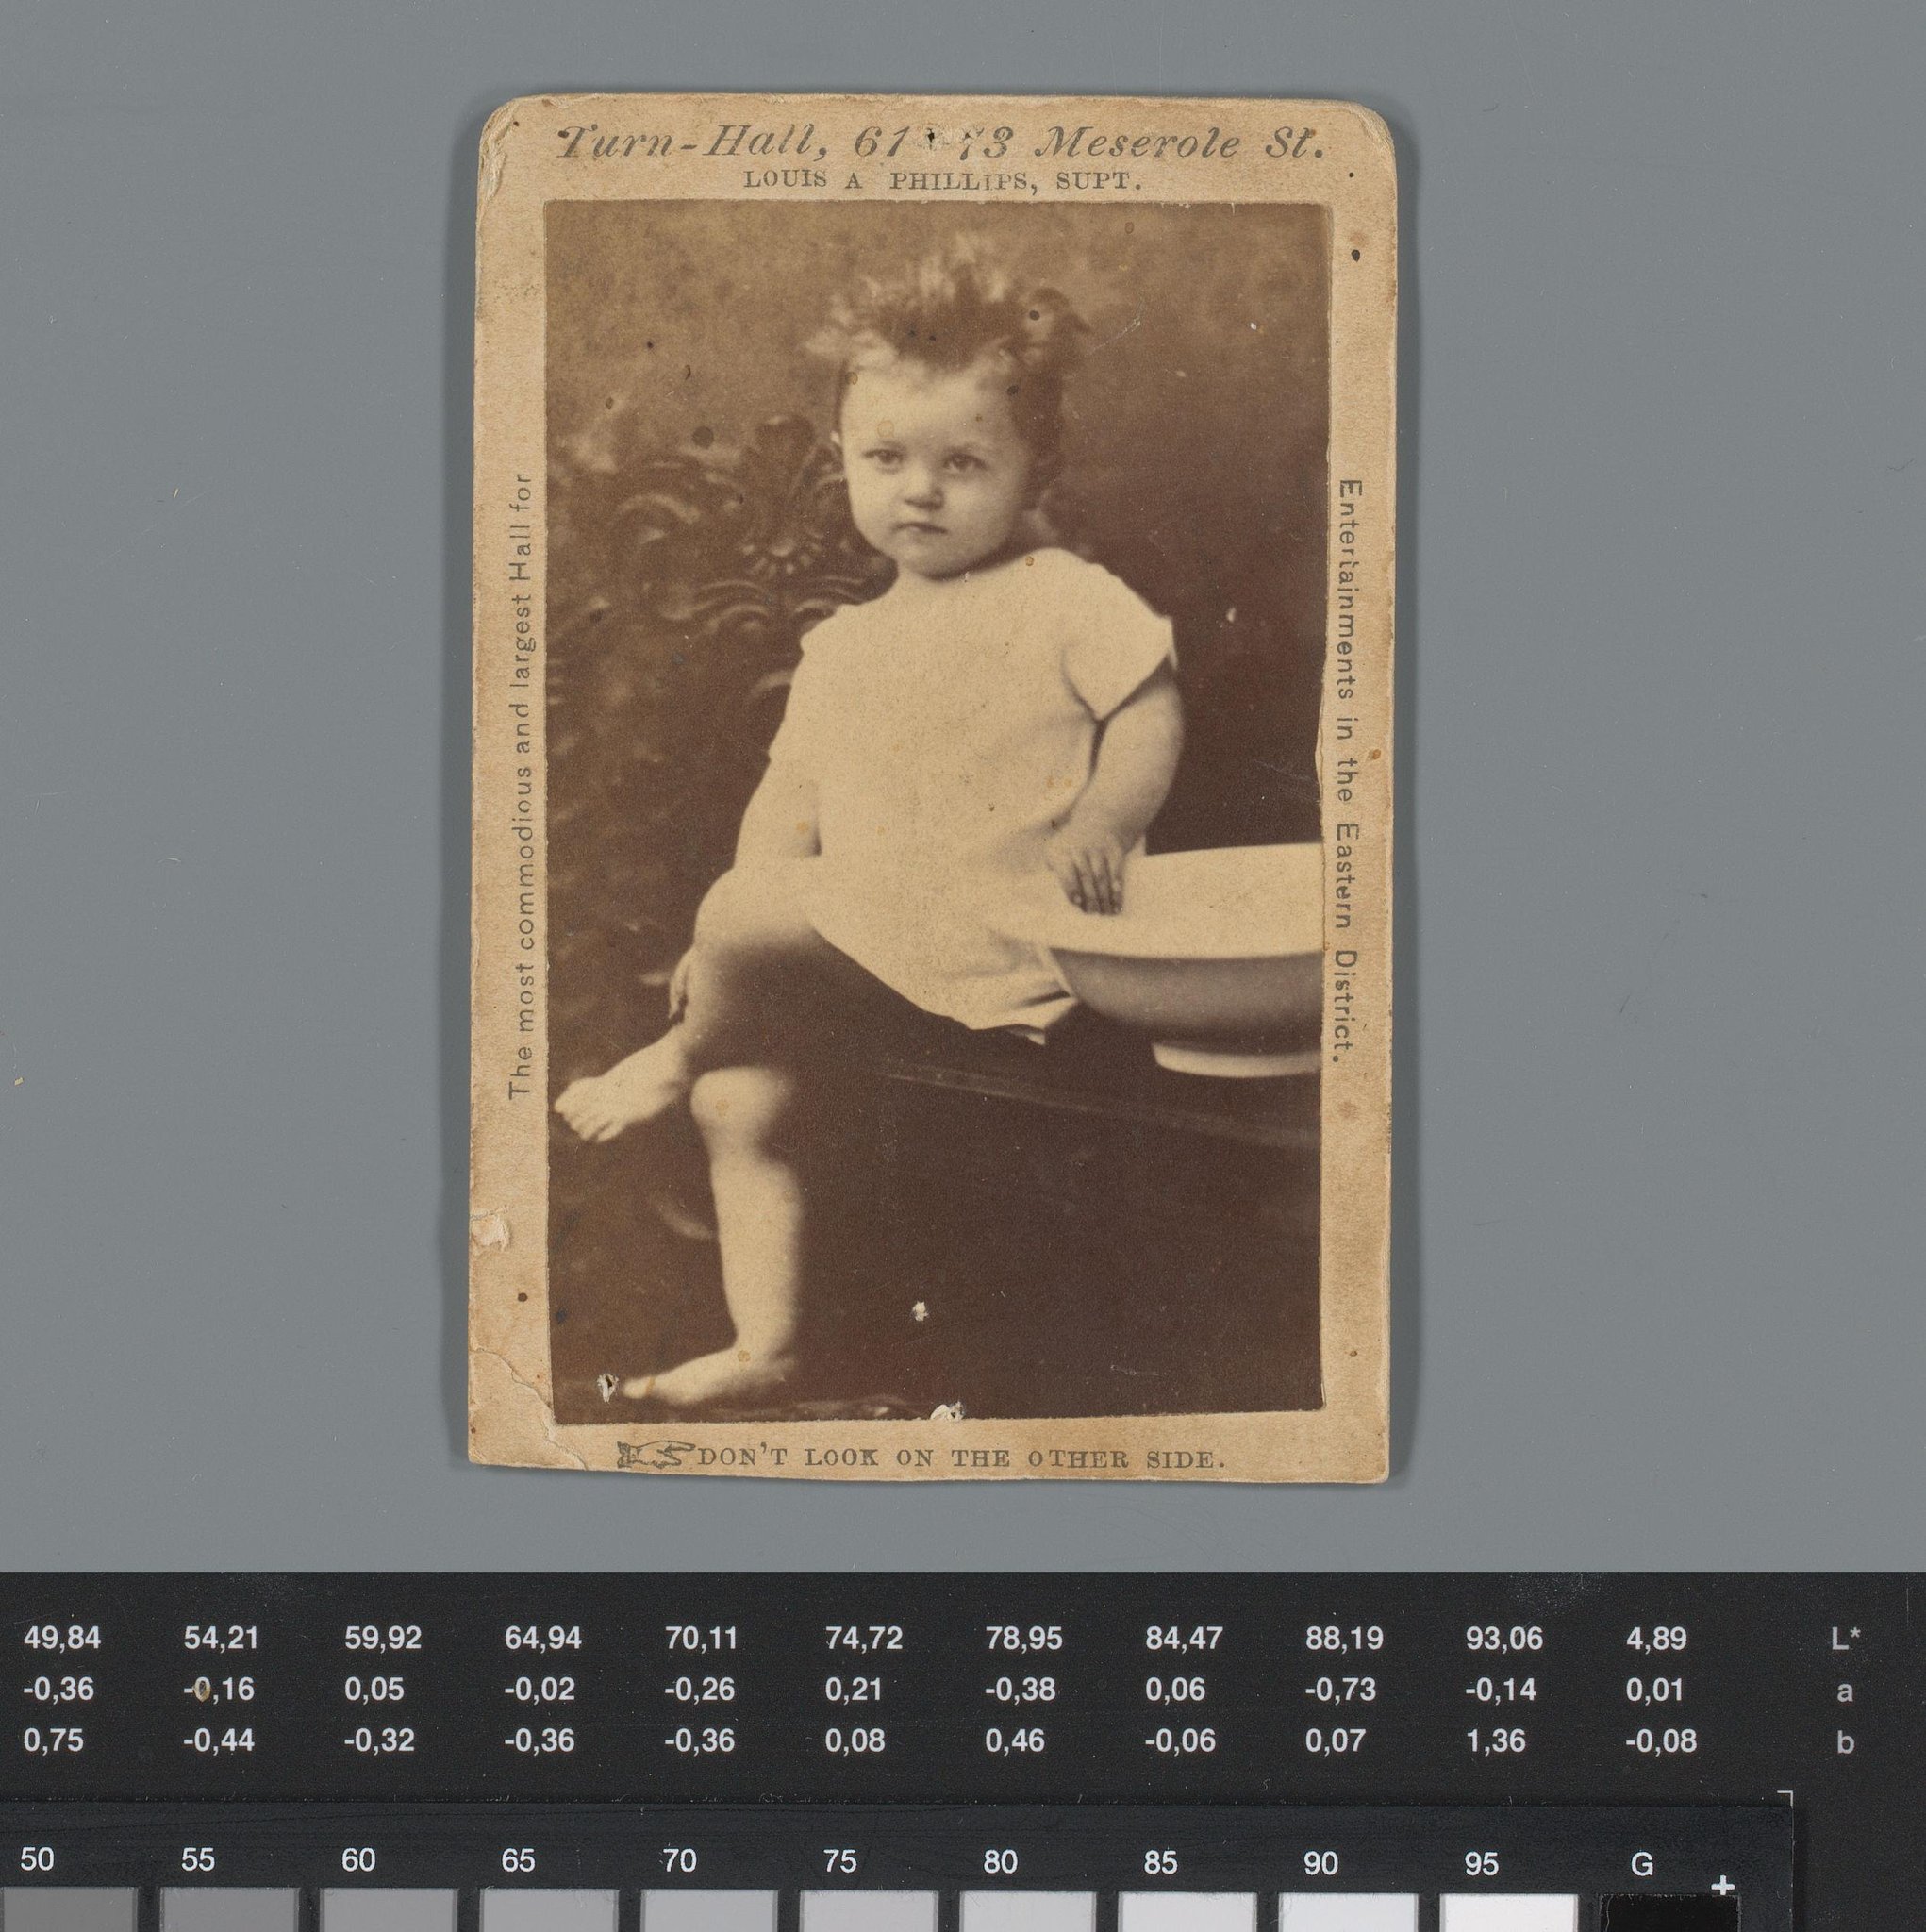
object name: carte de visite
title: Reclame voor verschillende zaken in een winkelcentrum te Brooklyn met een portret van een onbekend kind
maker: Anonymous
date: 1850-1915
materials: cardboard, photographic support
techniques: albumen print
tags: advertising, child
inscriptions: inscription: ‘Turn-Hall, 61-73 Meserole St. / Louis A Phillips, supt. / The most commodious and largest Hall for Entertainments in the Eastern District. / DON'T LOOK ON THE OTHER SIDE.’